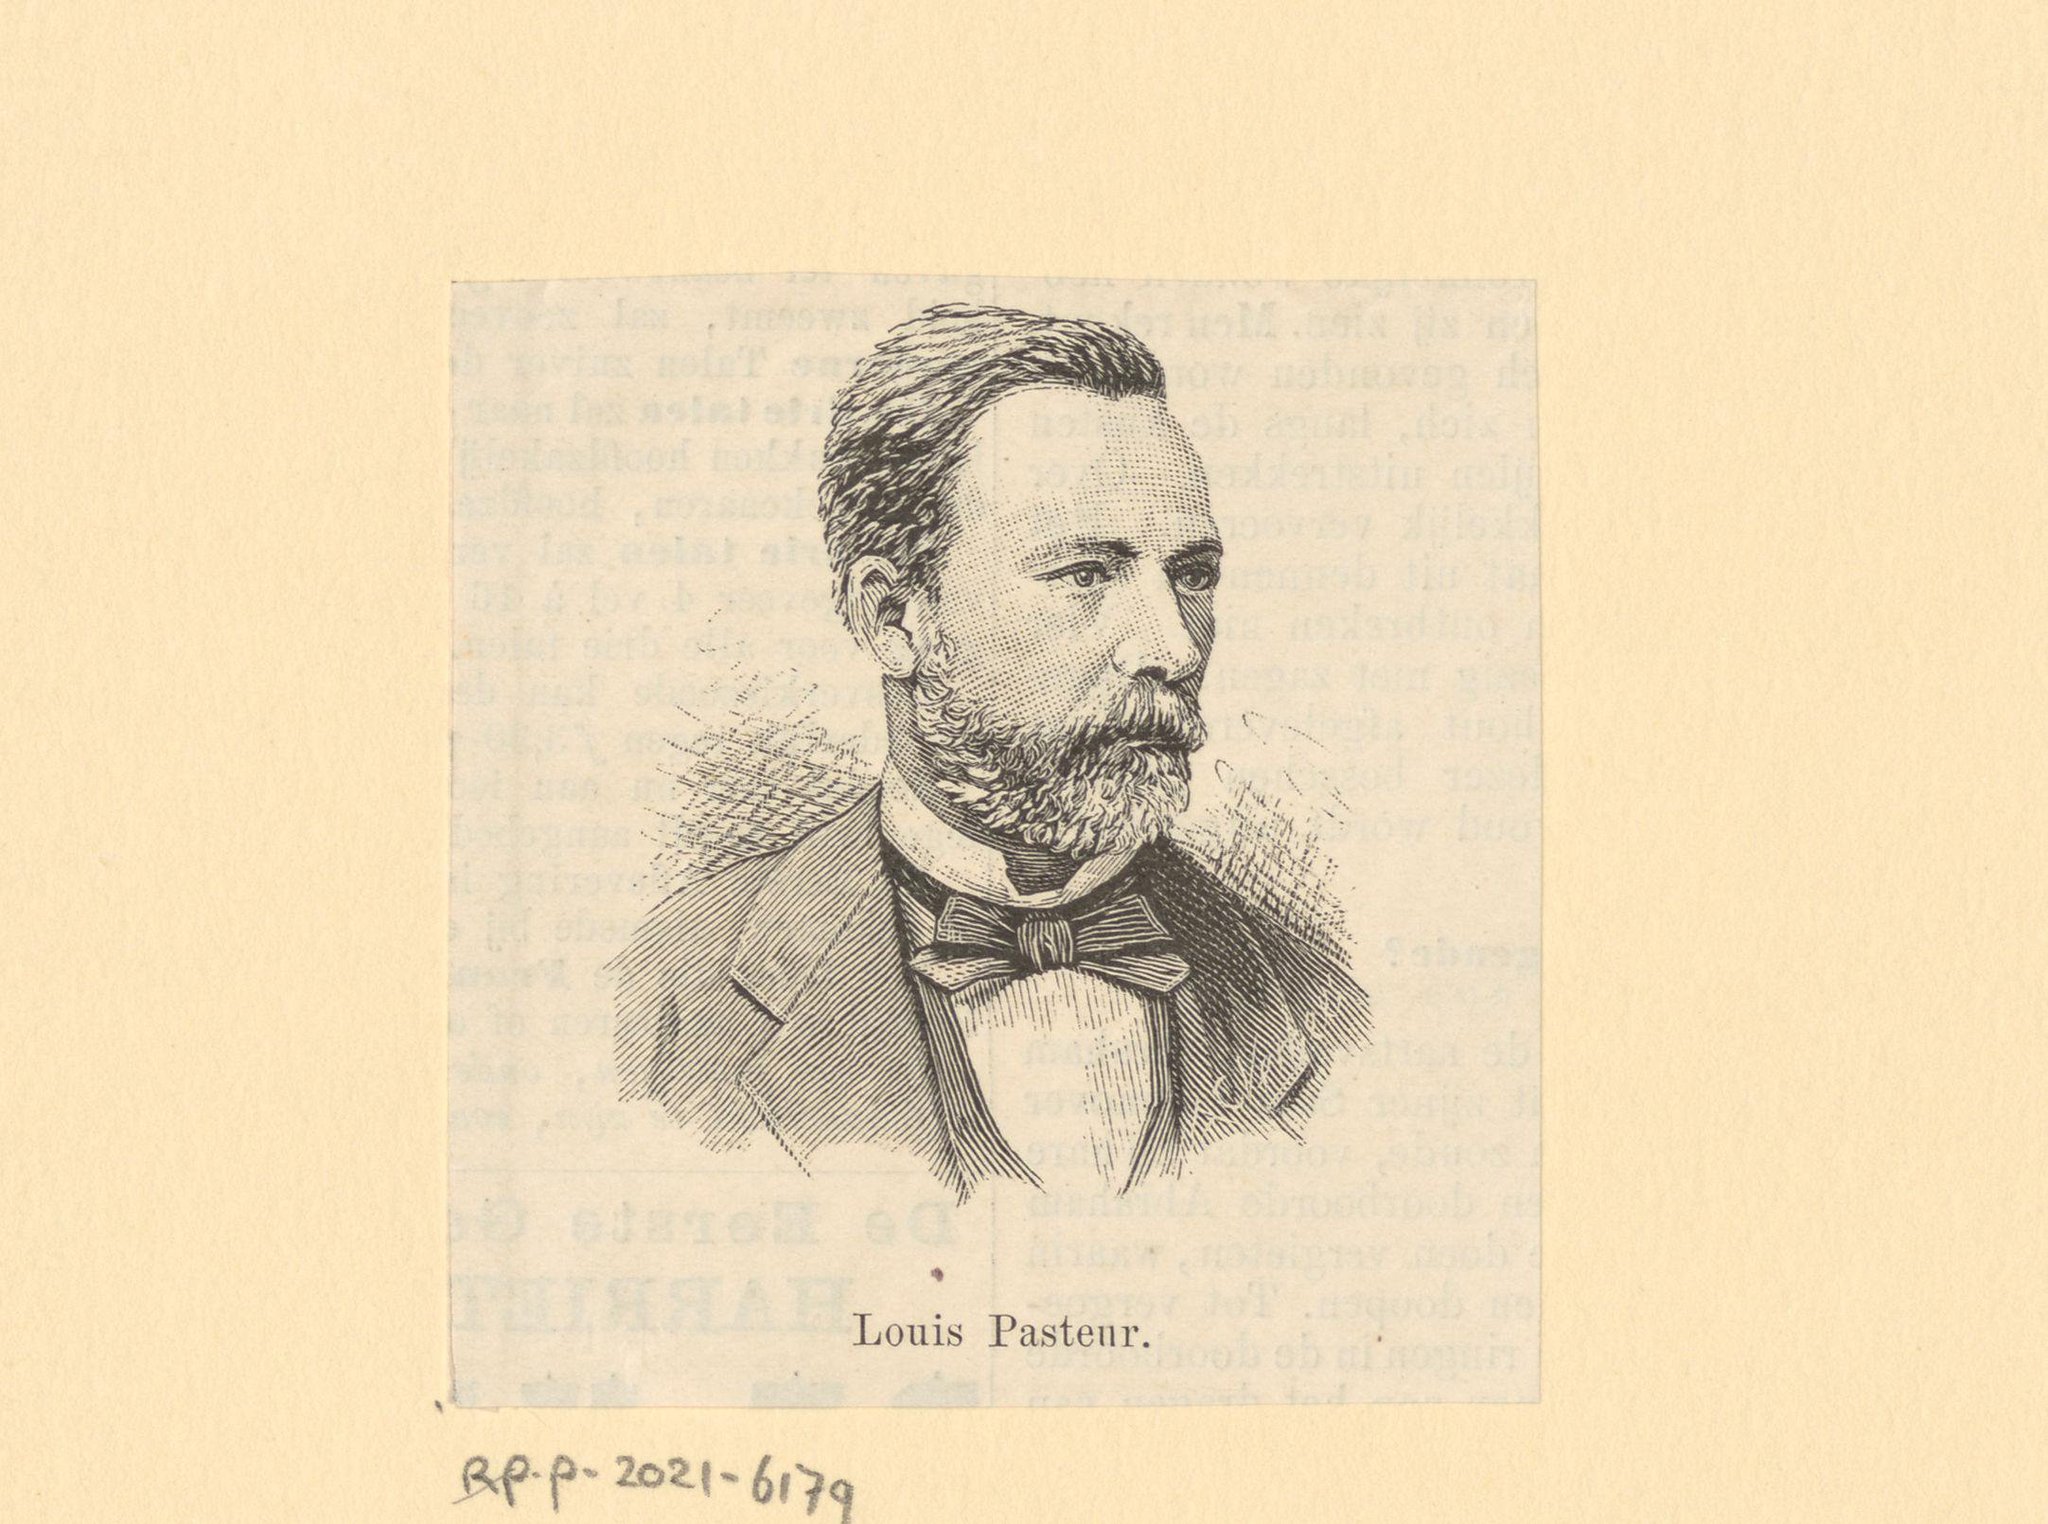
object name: print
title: Portret van Louis Pasteur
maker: Anonymous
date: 1885-1924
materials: paper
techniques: letterpress printing, engraving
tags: adult man, historical persons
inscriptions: mark: ‘A[?]C Ve[...]’